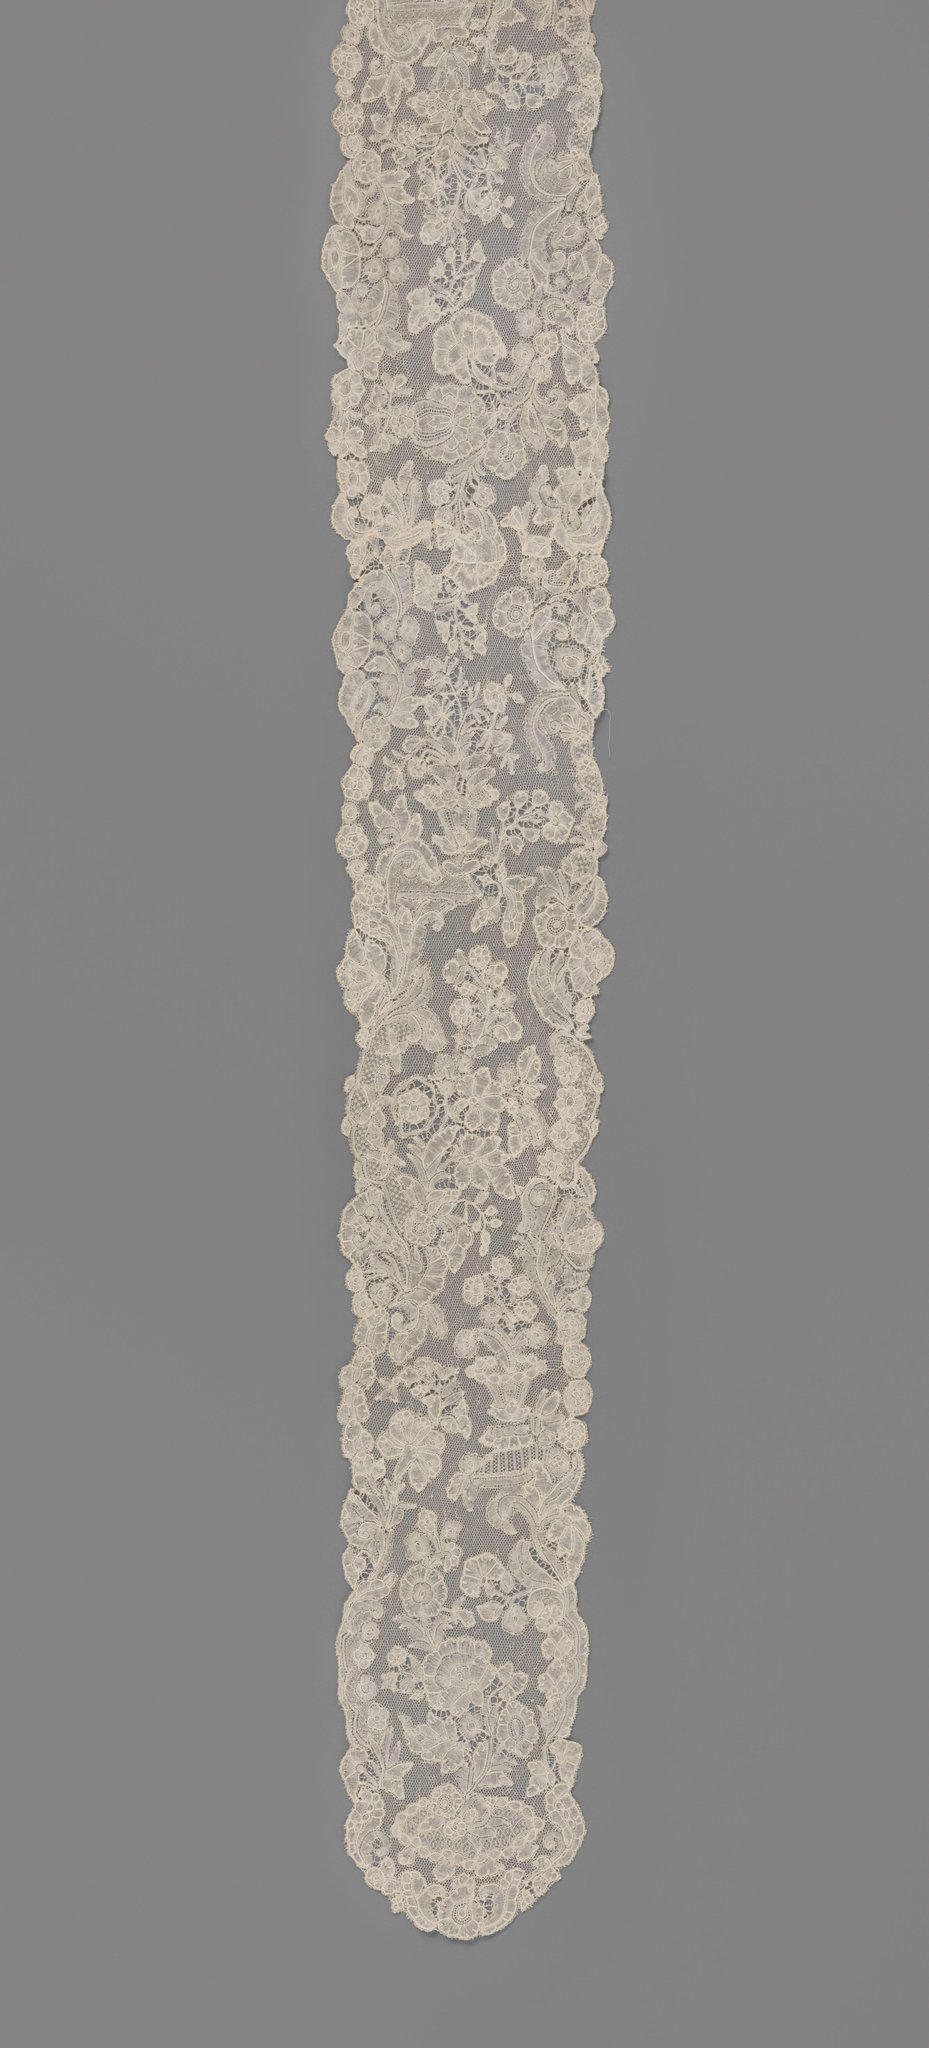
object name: lappet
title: Mutsenslip van kloskant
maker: Anonymous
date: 1725-1749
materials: linen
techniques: lace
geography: brussels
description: Mutsenslip van kloskant. Het patroon bestaat uit boeketten en bloemtakken. De geschulpte rand is afgezet met picots.